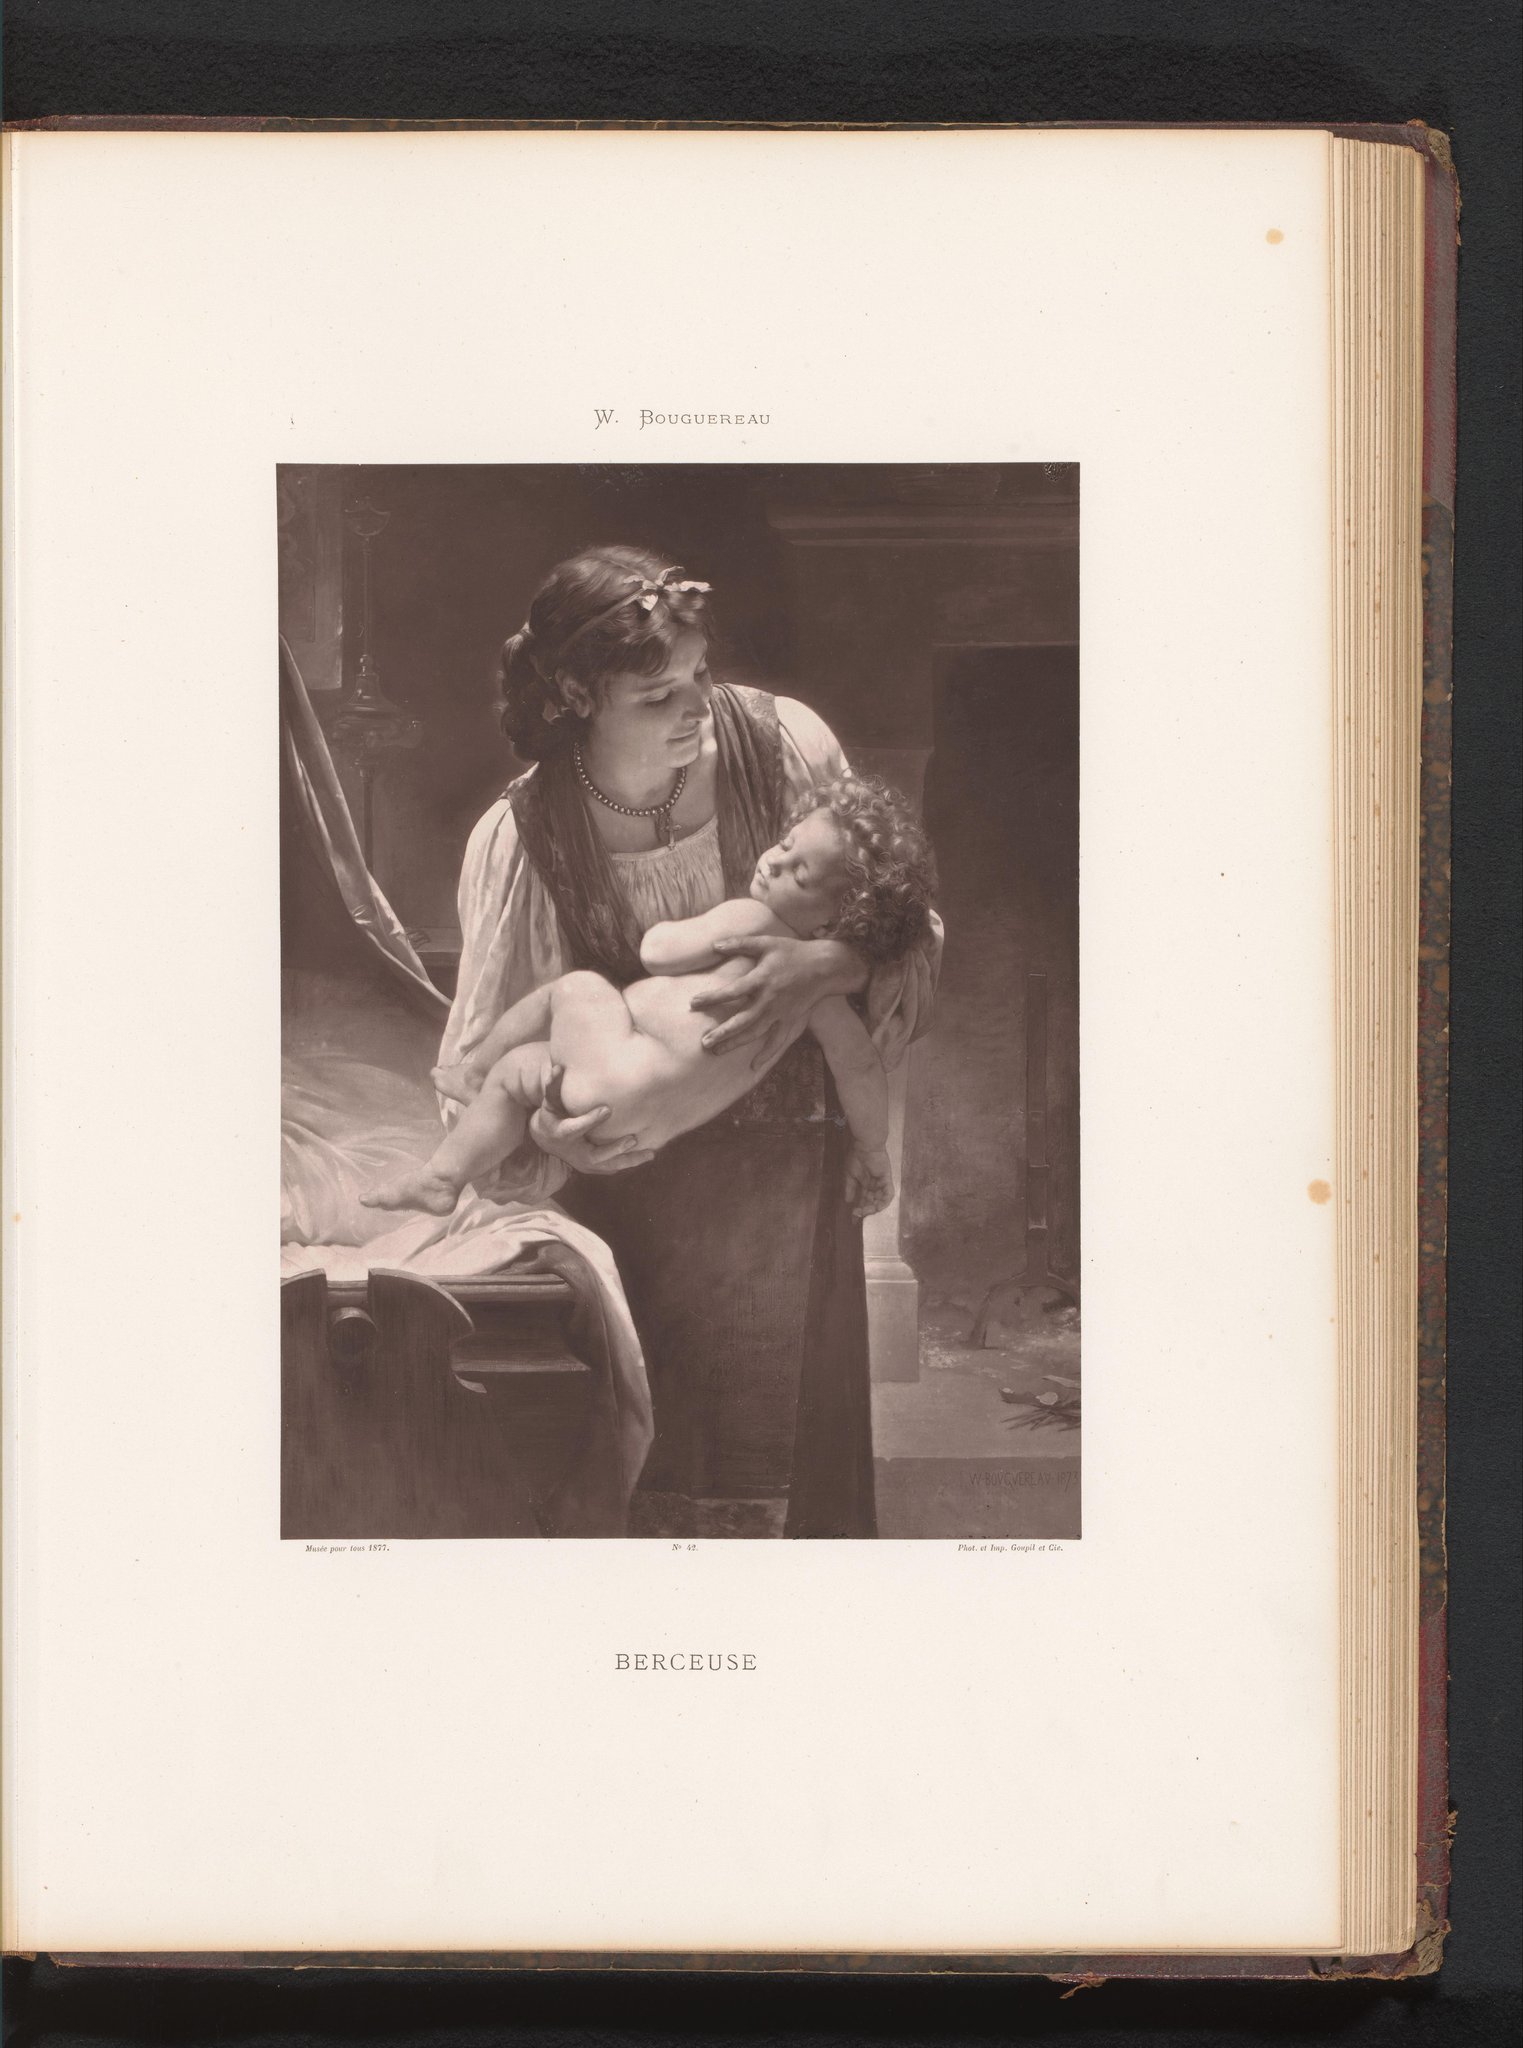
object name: page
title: Berceuse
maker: william-adolphe bouguereau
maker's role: draughtsman, painter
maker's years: 1825-1905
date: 1872-1879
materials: paper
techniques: woodburytype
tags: watching a sleeping child, singing lullabies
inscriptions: inscription: ‘Musée pour tous 1877/ No 41’